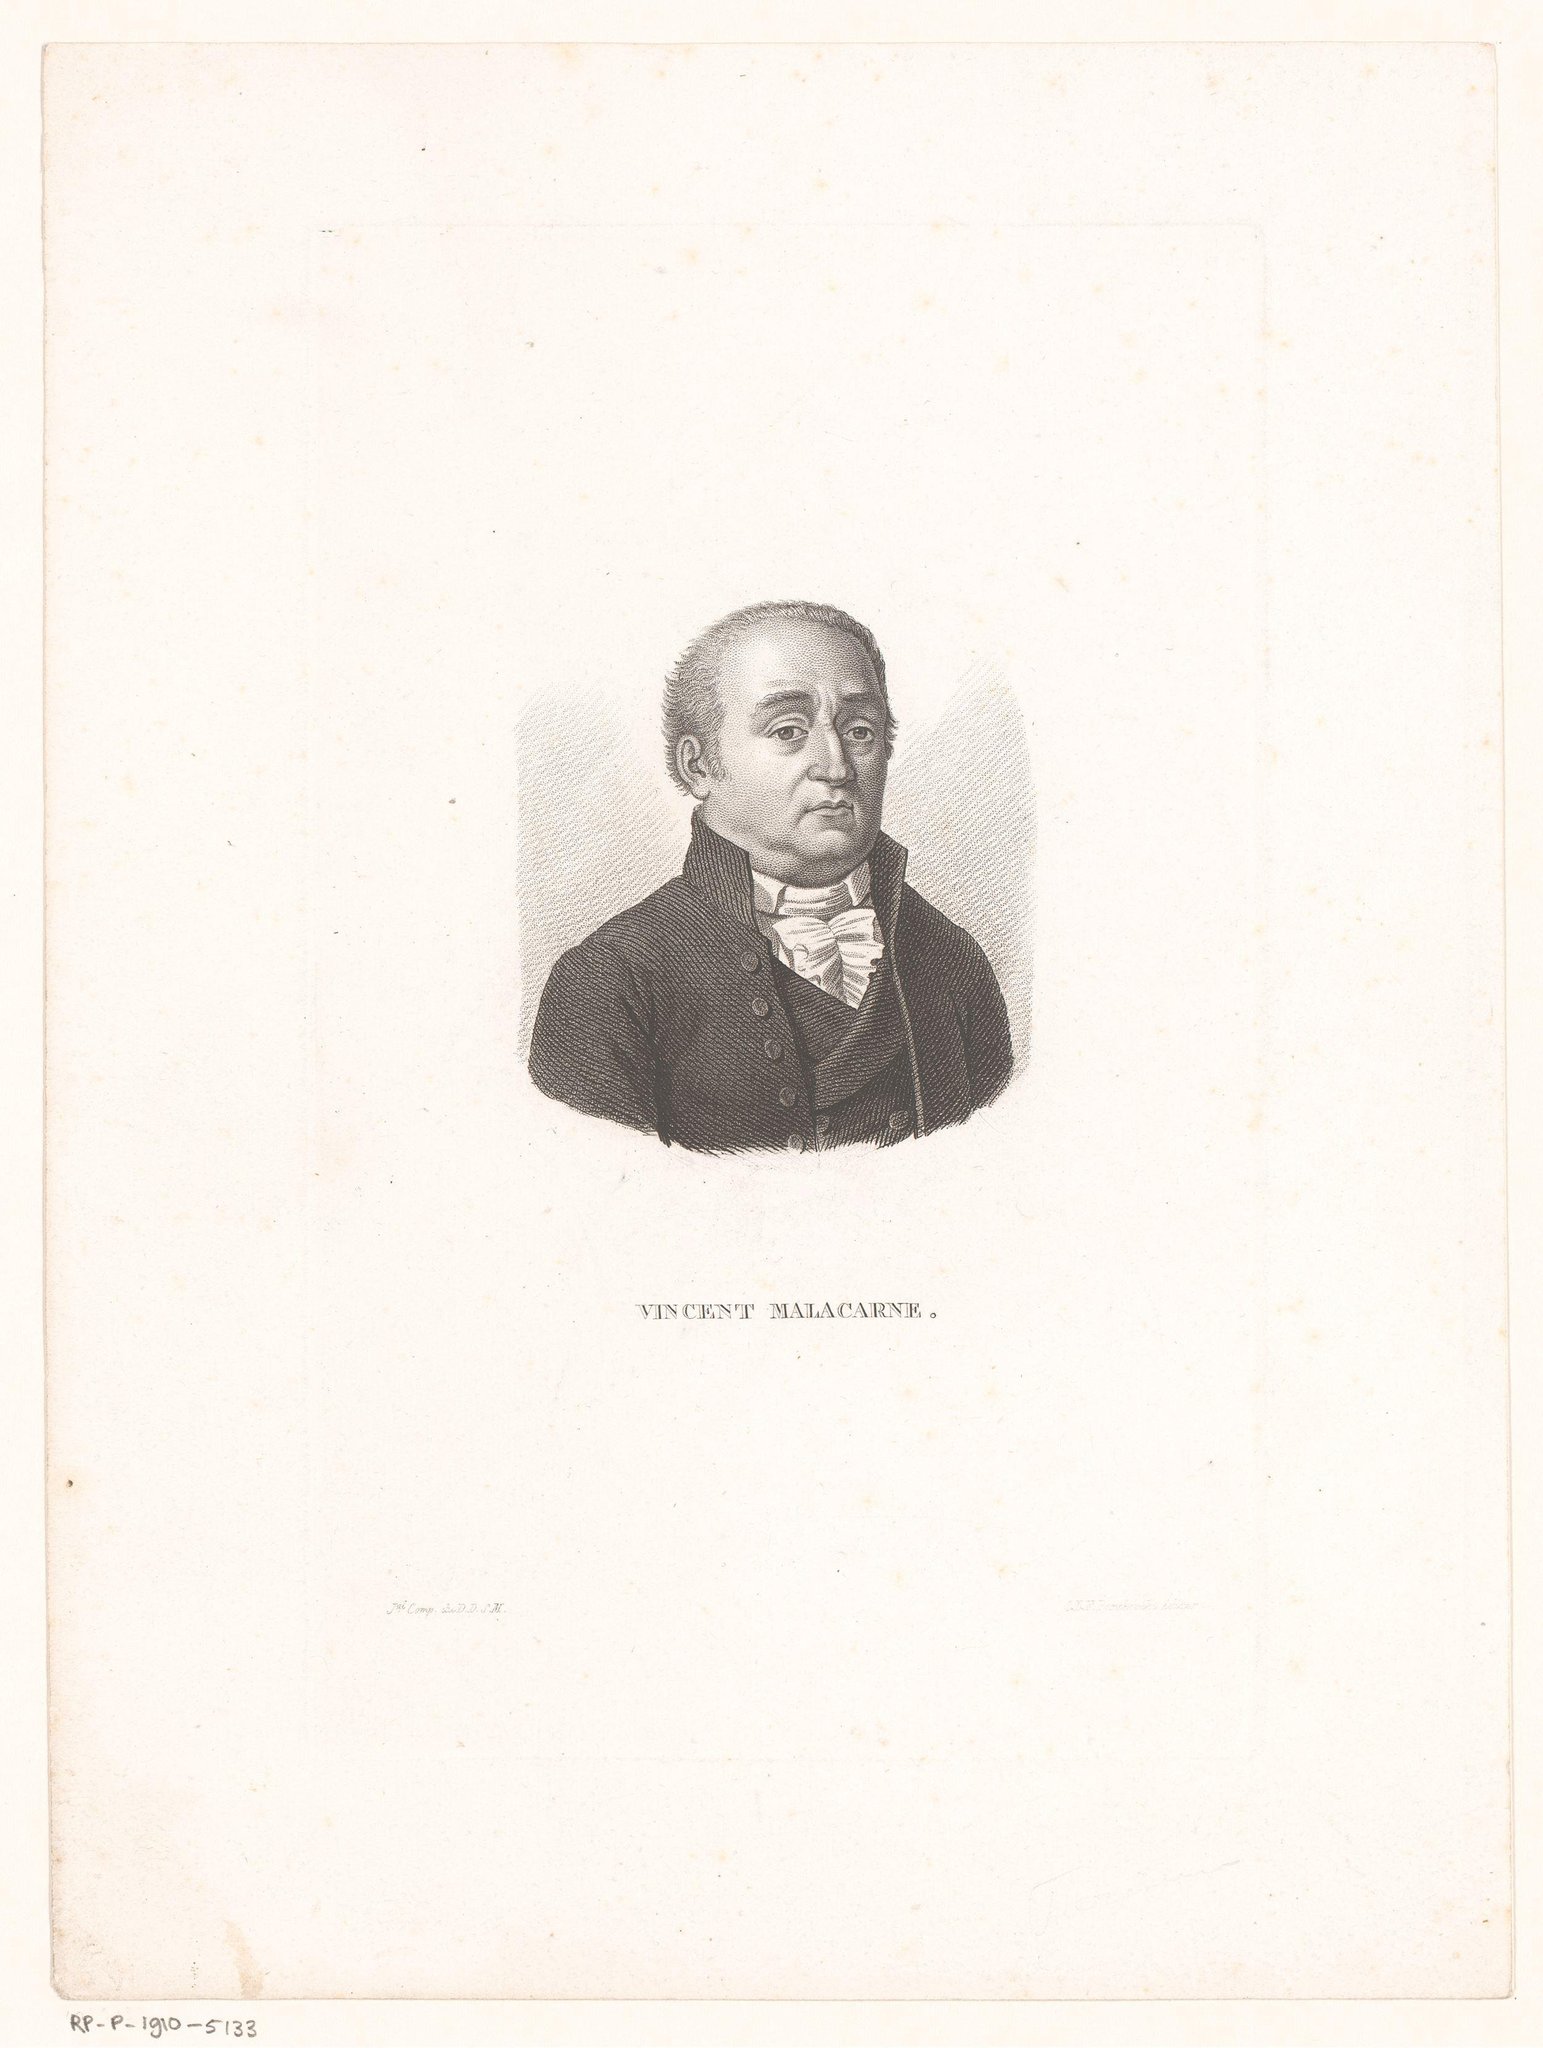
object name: book illustration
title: Portret van Vincenzo Malacarne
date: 1818-1832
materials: paper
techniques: engraving, roulette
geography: paris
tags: historical persons, barber; surgeon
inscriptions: collector's mark: Lugt 2228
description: Prent uit: Journal complémentaire du Dictionnaire des sciences médicales. Parijs: Panckoucke, Charles Louis Fleury, 1818-1832.